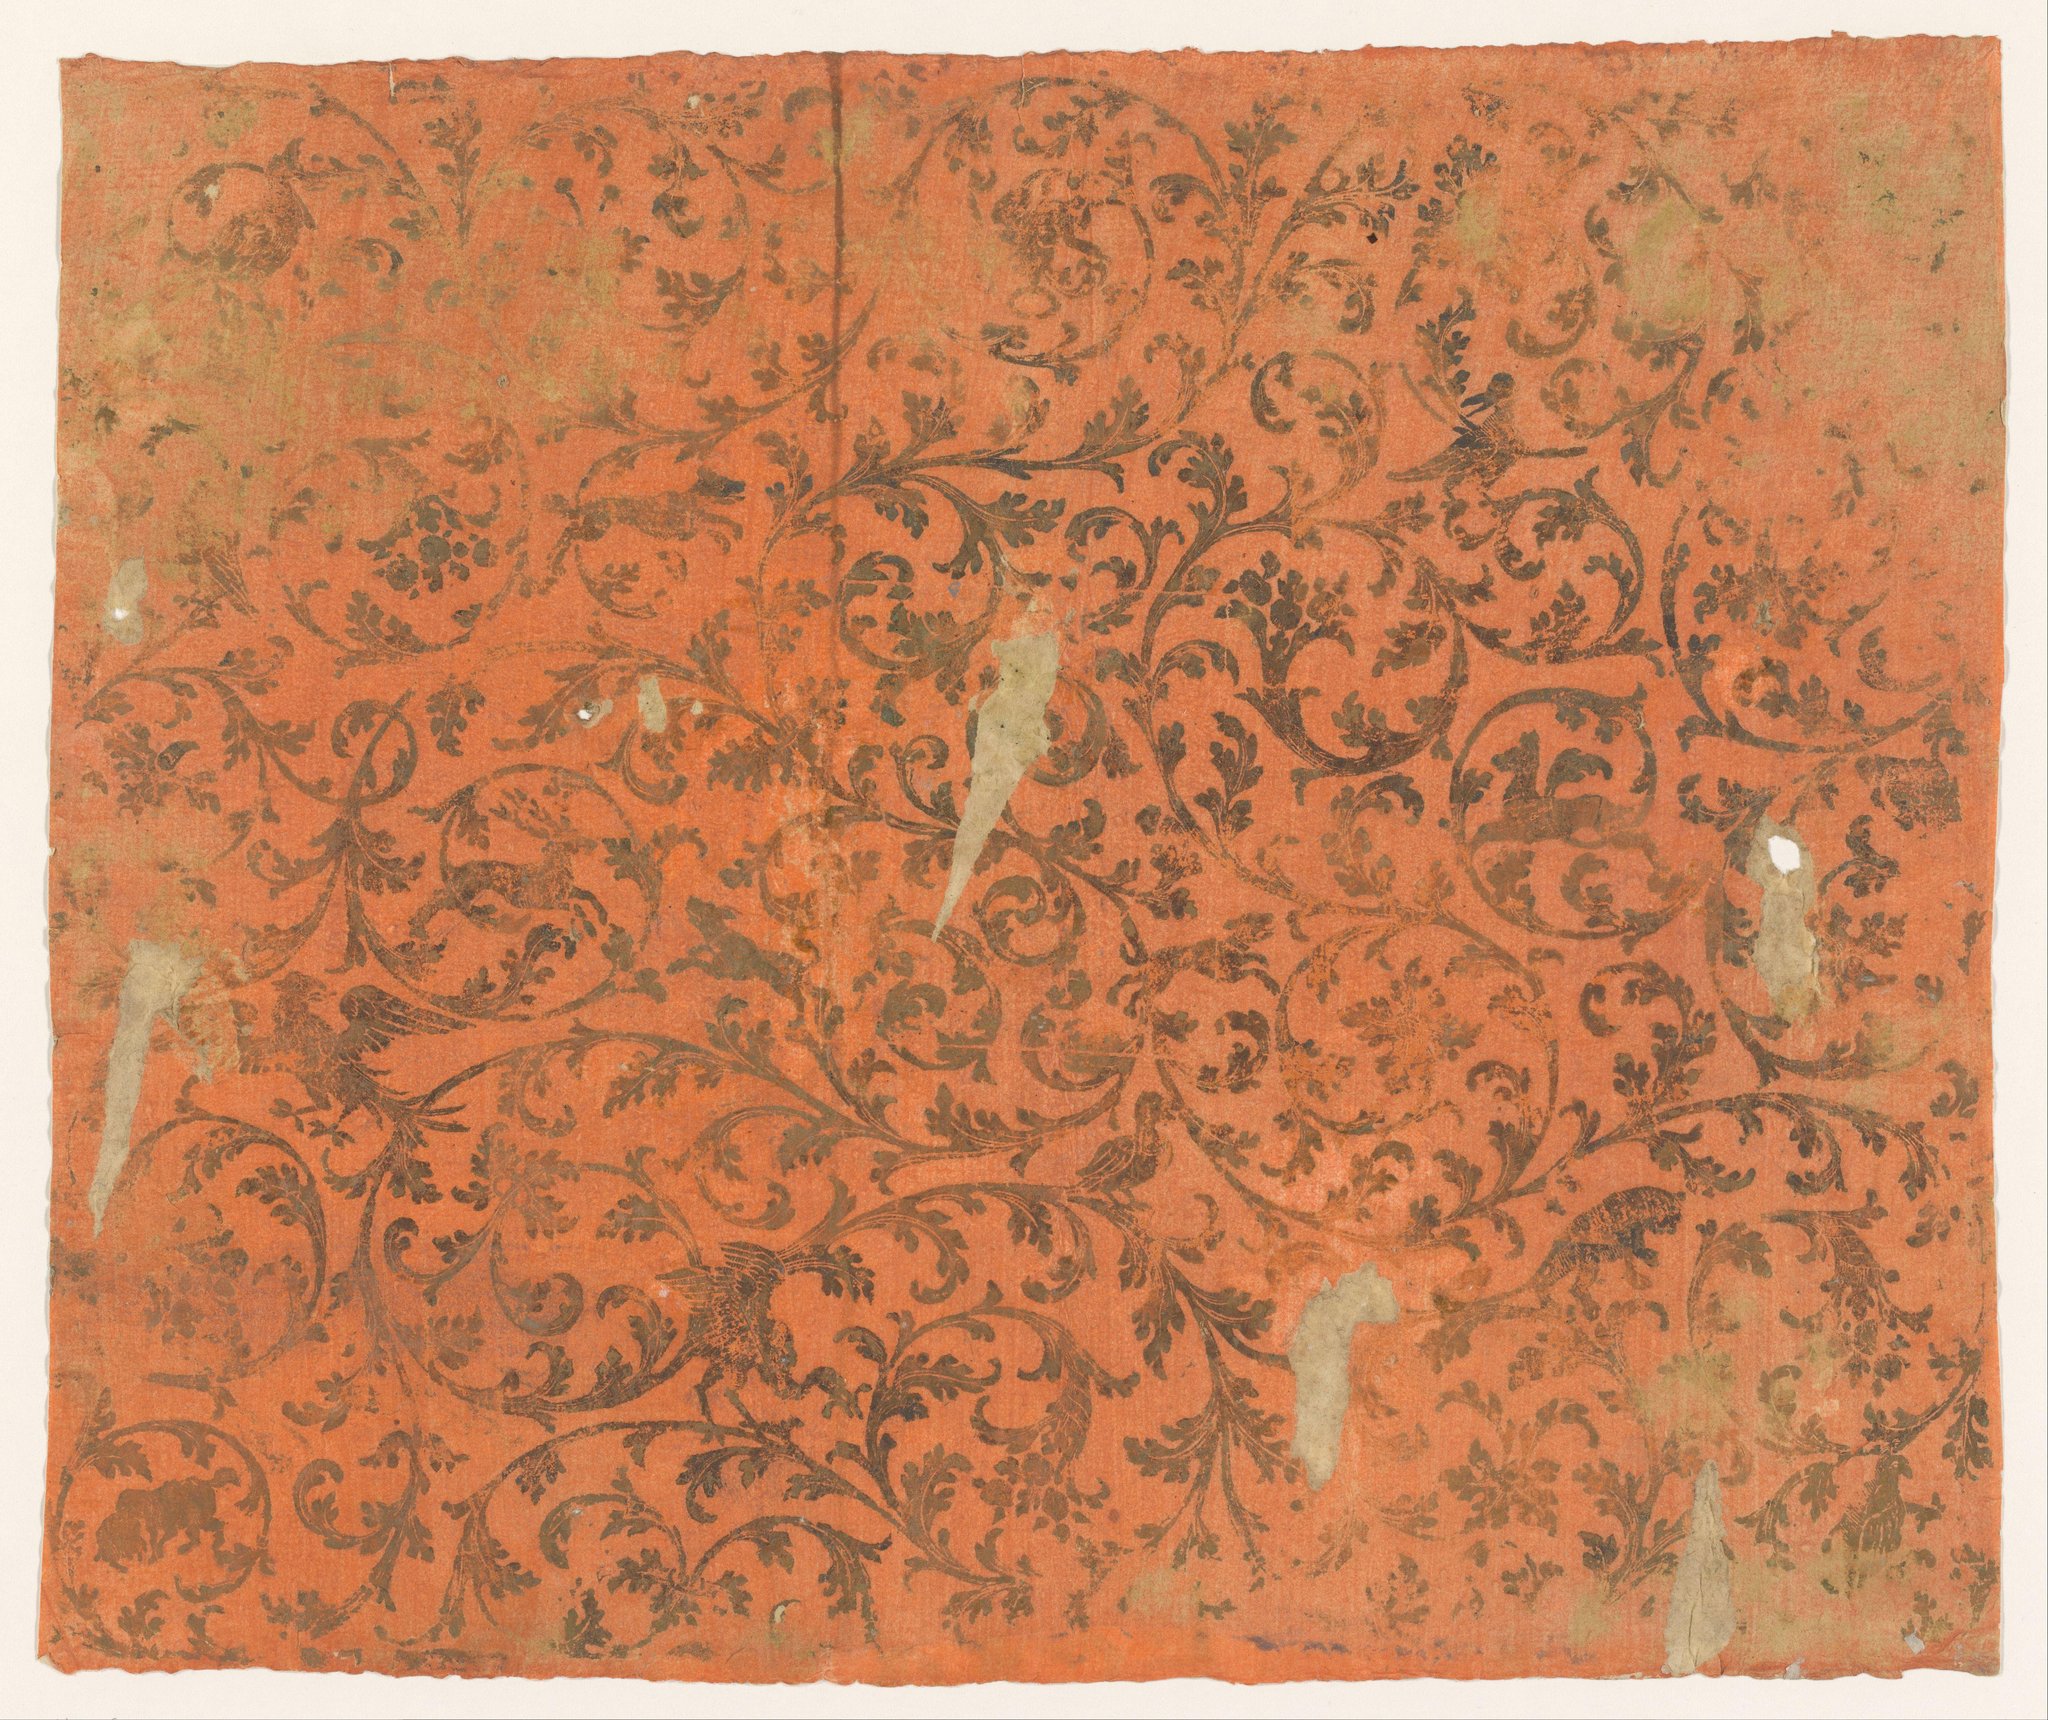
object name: brocade paper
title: Blad met ranken met bloemen en dieren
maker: Anonymous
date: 1700-1750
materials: gold leaf, paint, paper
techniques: relief print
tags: ornament derived from animal forms, ornament derived from plant forms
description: Blad met ranken met bloemen en dieren, linksboven vogel, linksonder jachthond, rechtsonder vogel.